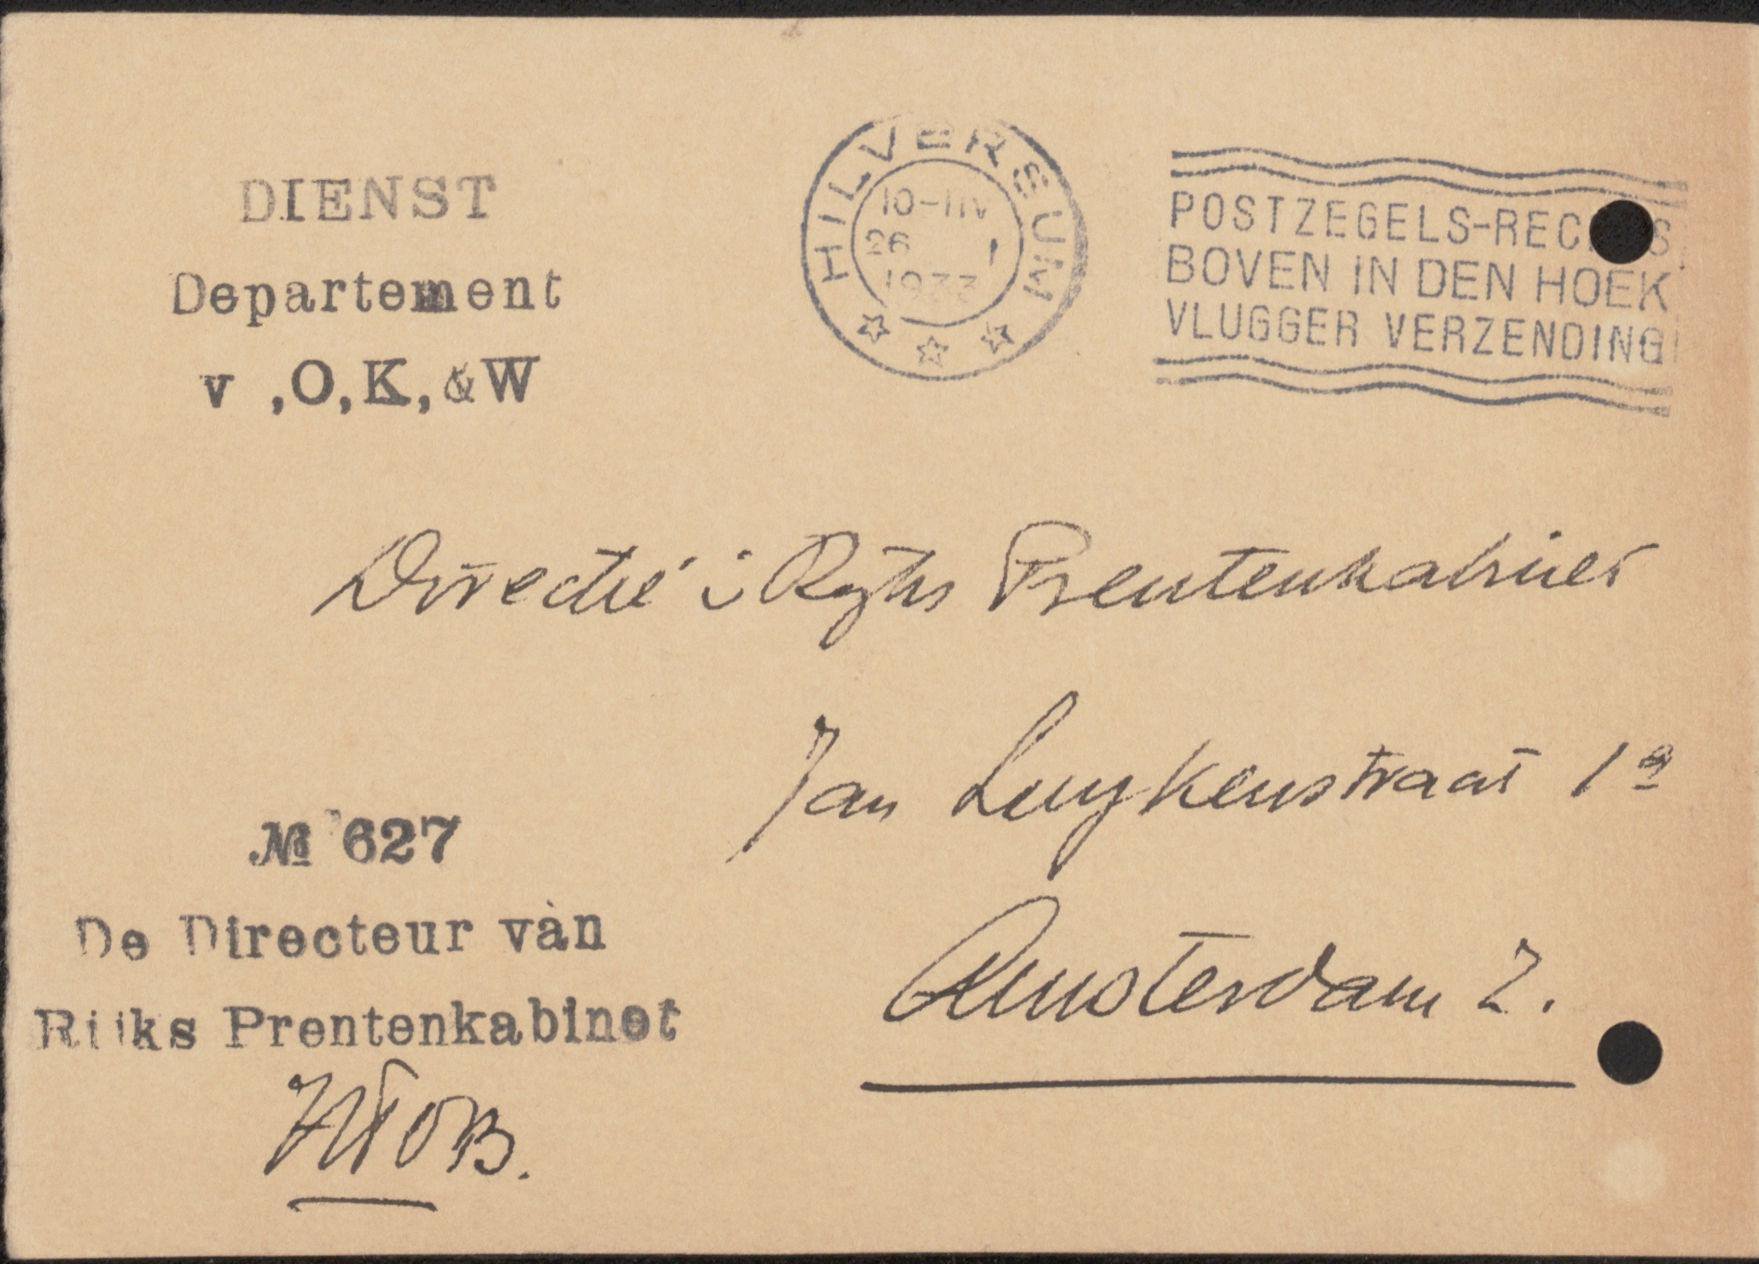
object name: letter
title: Brief aan jonkheer Hendrik Teding van Berkhout (1879-1969)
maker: reinier willem petrus de vries (1874-1953)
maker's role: draughtsman, print maker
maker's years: 1874-1953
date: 1933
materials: ink, paper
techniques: pen, writing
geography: hilversum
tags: jonkheer hendrik teding van berkhout (1879-1969), amsterdam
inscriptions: name: ‘DIENST DEPARTEMENT v, O, K, & W No 627, De Directeur van s Rijks Prentenkabinet H.Teding v Berkhout.’